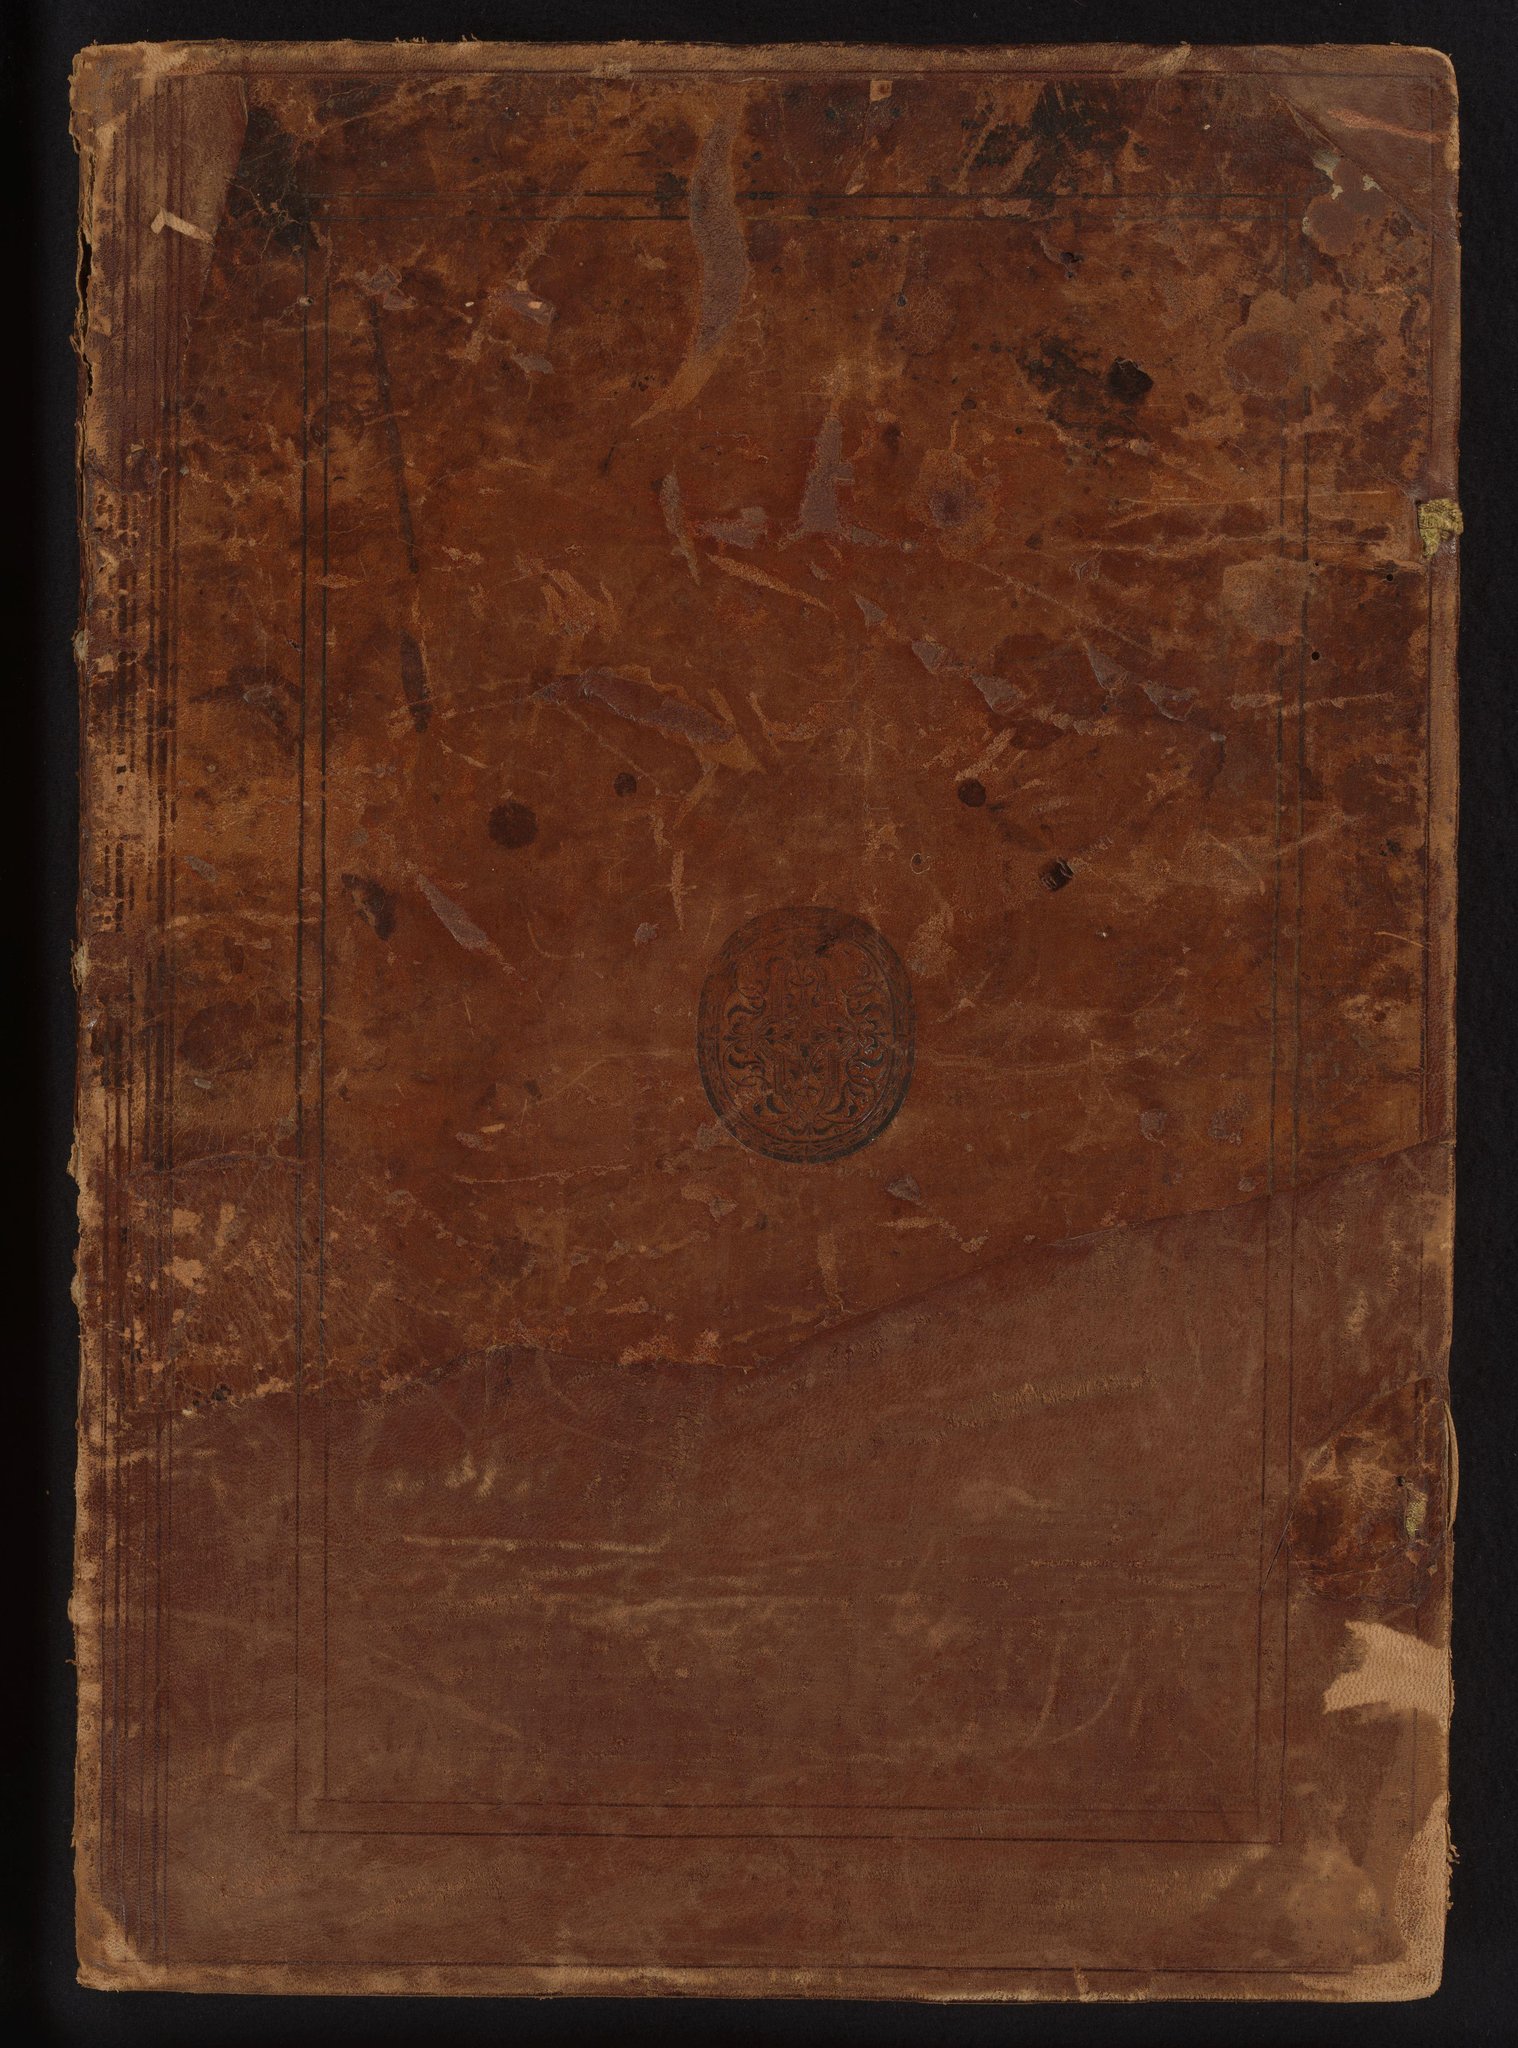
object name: book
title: Perspectiva corporum regularium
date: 1568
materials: cardboard, leather, paper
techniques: bookbinding, printing, etching, letterpress printing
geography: nuremberg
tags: planimetry, geometry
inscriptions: collector's mark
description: Boek met een ex libris geplakt op het voorste dekblad, titelpagina en 43 gravures op 44 bladen. Het boek bestaat uit negen delen met regelmatig gevormde objecten als onderwerp. De veelvlakken, of polyhedra, zijn in oplopende complexiteit en met toenemend aantal zijdes weergegeven. Wenzel Jamnitzer beoogde wiskundige, ruimtelijke en kosmologische theorieën uit geschriften als Plato's 'Timaeus' en werken van Euclides van Alexandrië op een innovatieve manier te combineren en visualiseren door ze perspectivisch weer te geven in spiegel- en rotatiesymmetrie. In de delen worden de vier elementen vertegenwoordigd door een (afgeknot) veelvlak: vuur door de tetraëder, lucht door de octaëder, aarde door de hexaëder (kubus) en water door de icosaëder. De dodecaëder representeert het universum.